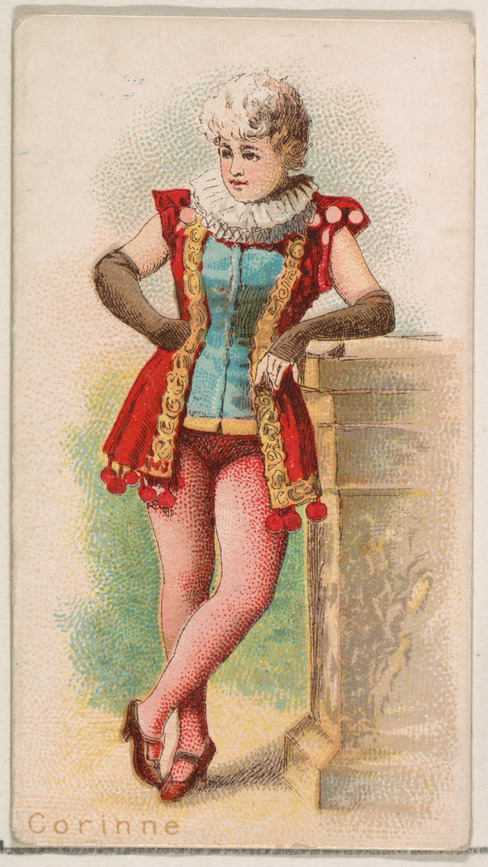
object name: print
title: Corinne, from the Ballet Queens series (N182) issued by Wm. S. Kimball & Co.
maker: william s. kimball & company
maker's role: publisher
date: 1889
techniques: color lithograph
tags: women,dancers